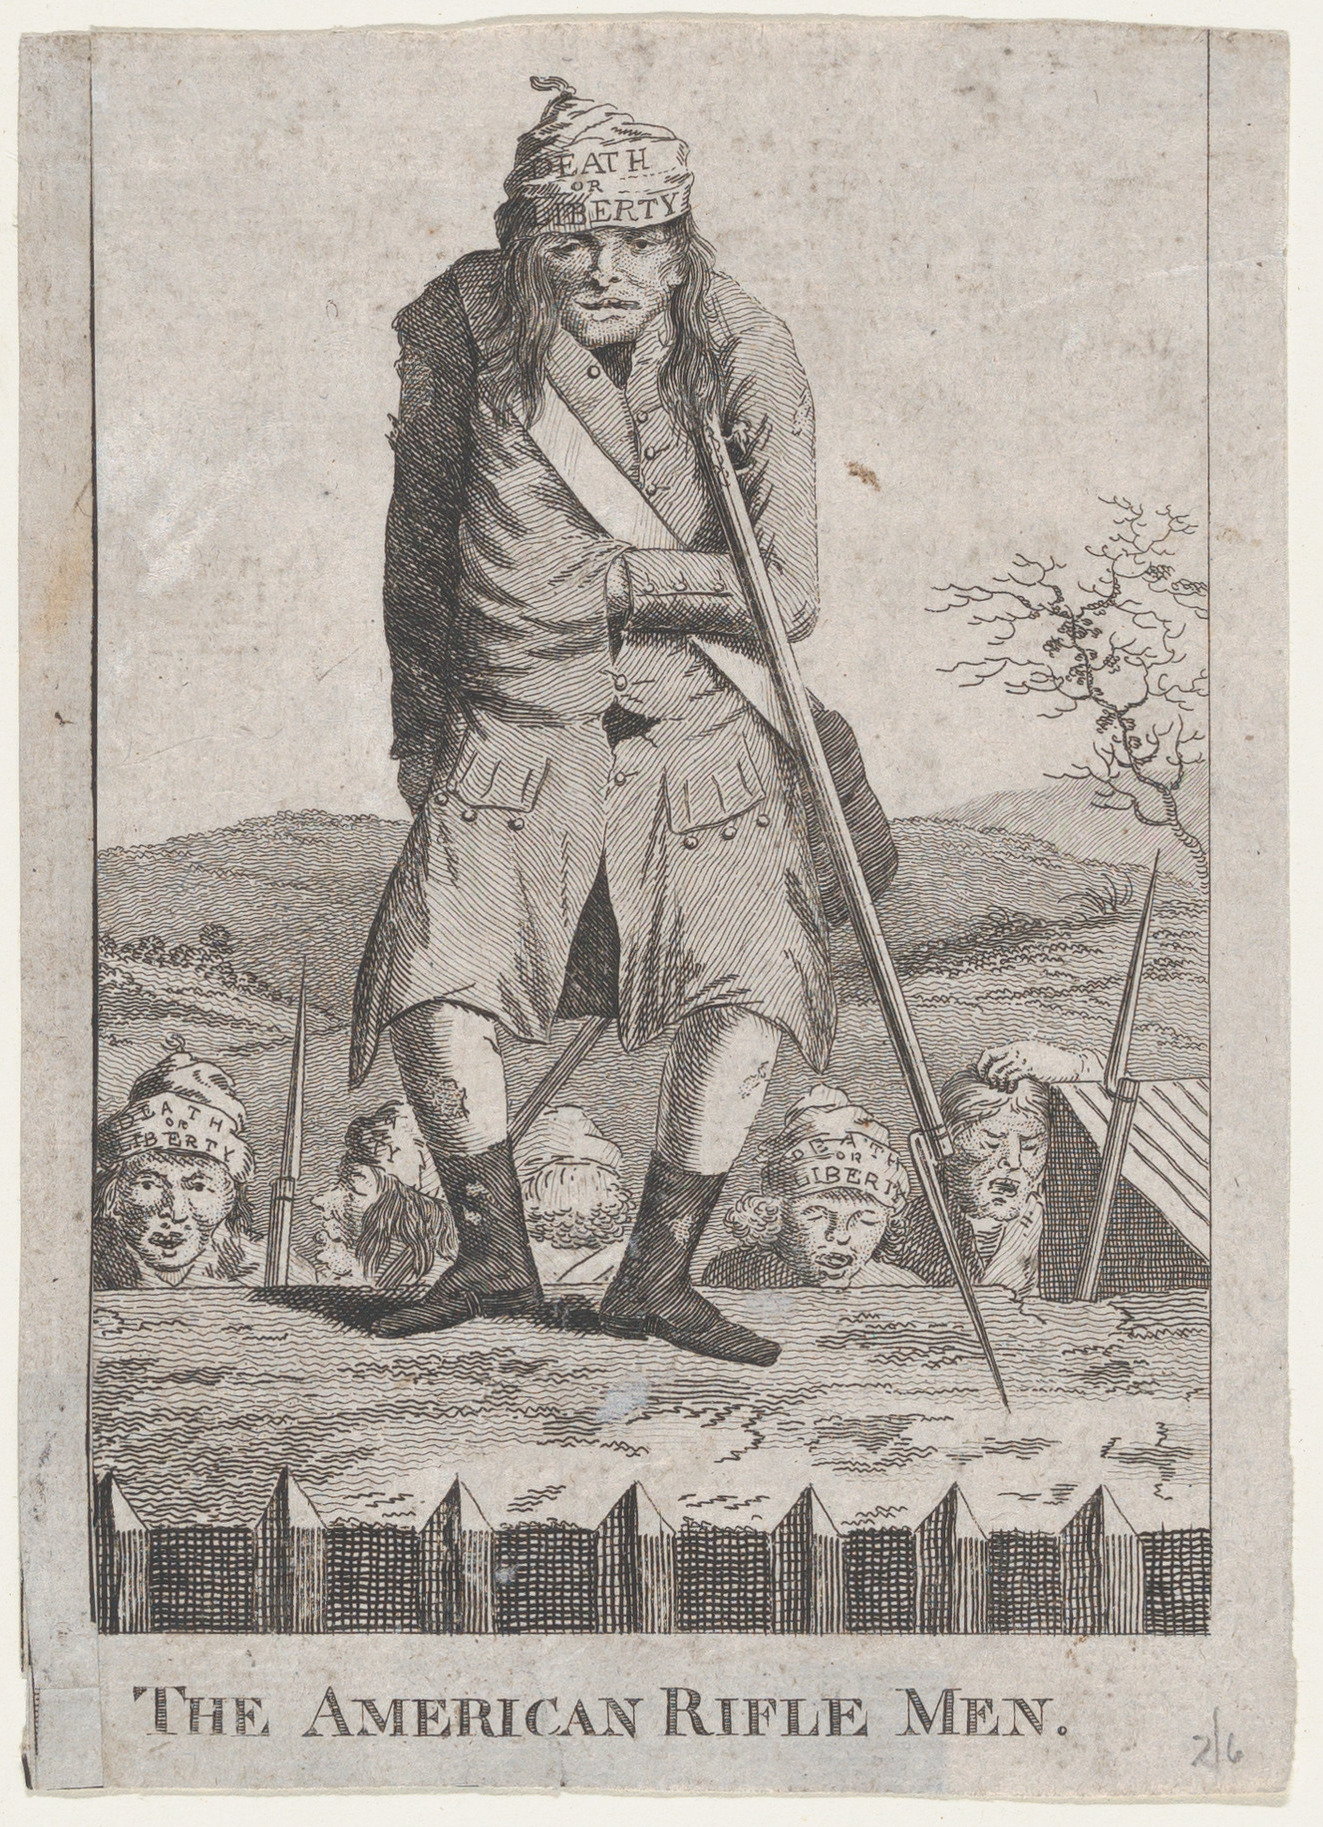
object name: print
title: The American Rifle Men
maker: anonymous, british, 18th century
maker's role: artist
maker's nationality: british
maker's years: 1700-1800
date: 1776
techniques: engraving, etching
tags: satire,american revolution,men